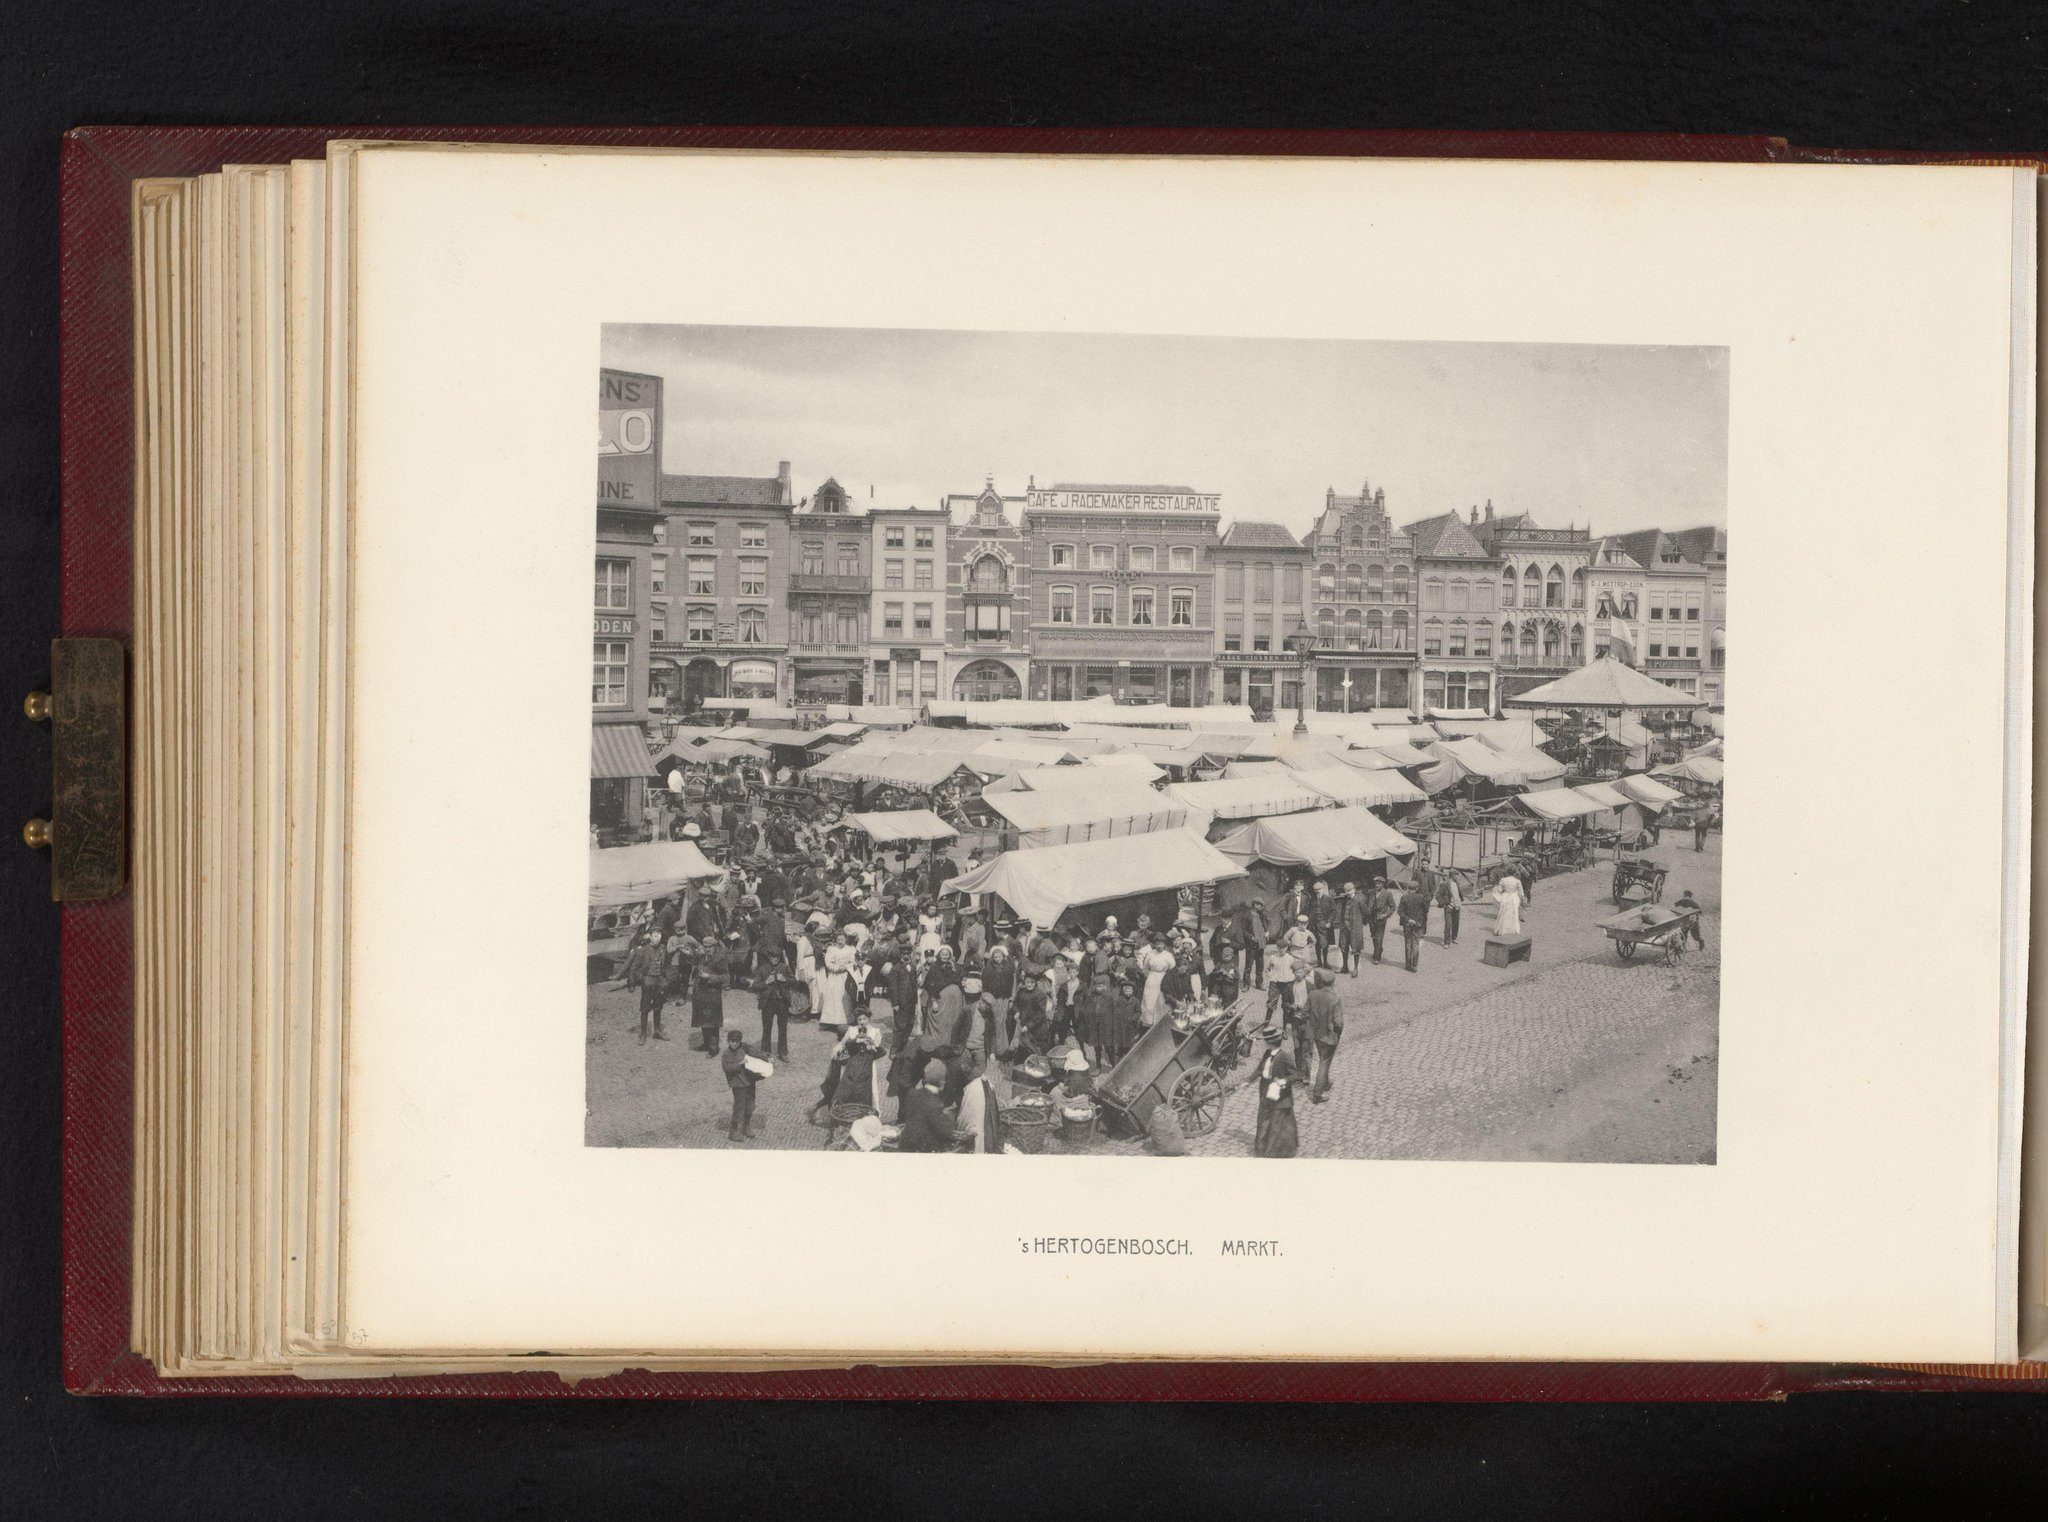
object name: album leaf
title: 's Hertogenbosch Markt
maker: Anonymous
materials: paper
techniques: photograph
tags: historical persons, market, den bosch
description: Deze pagina maakt deel uit van een album.